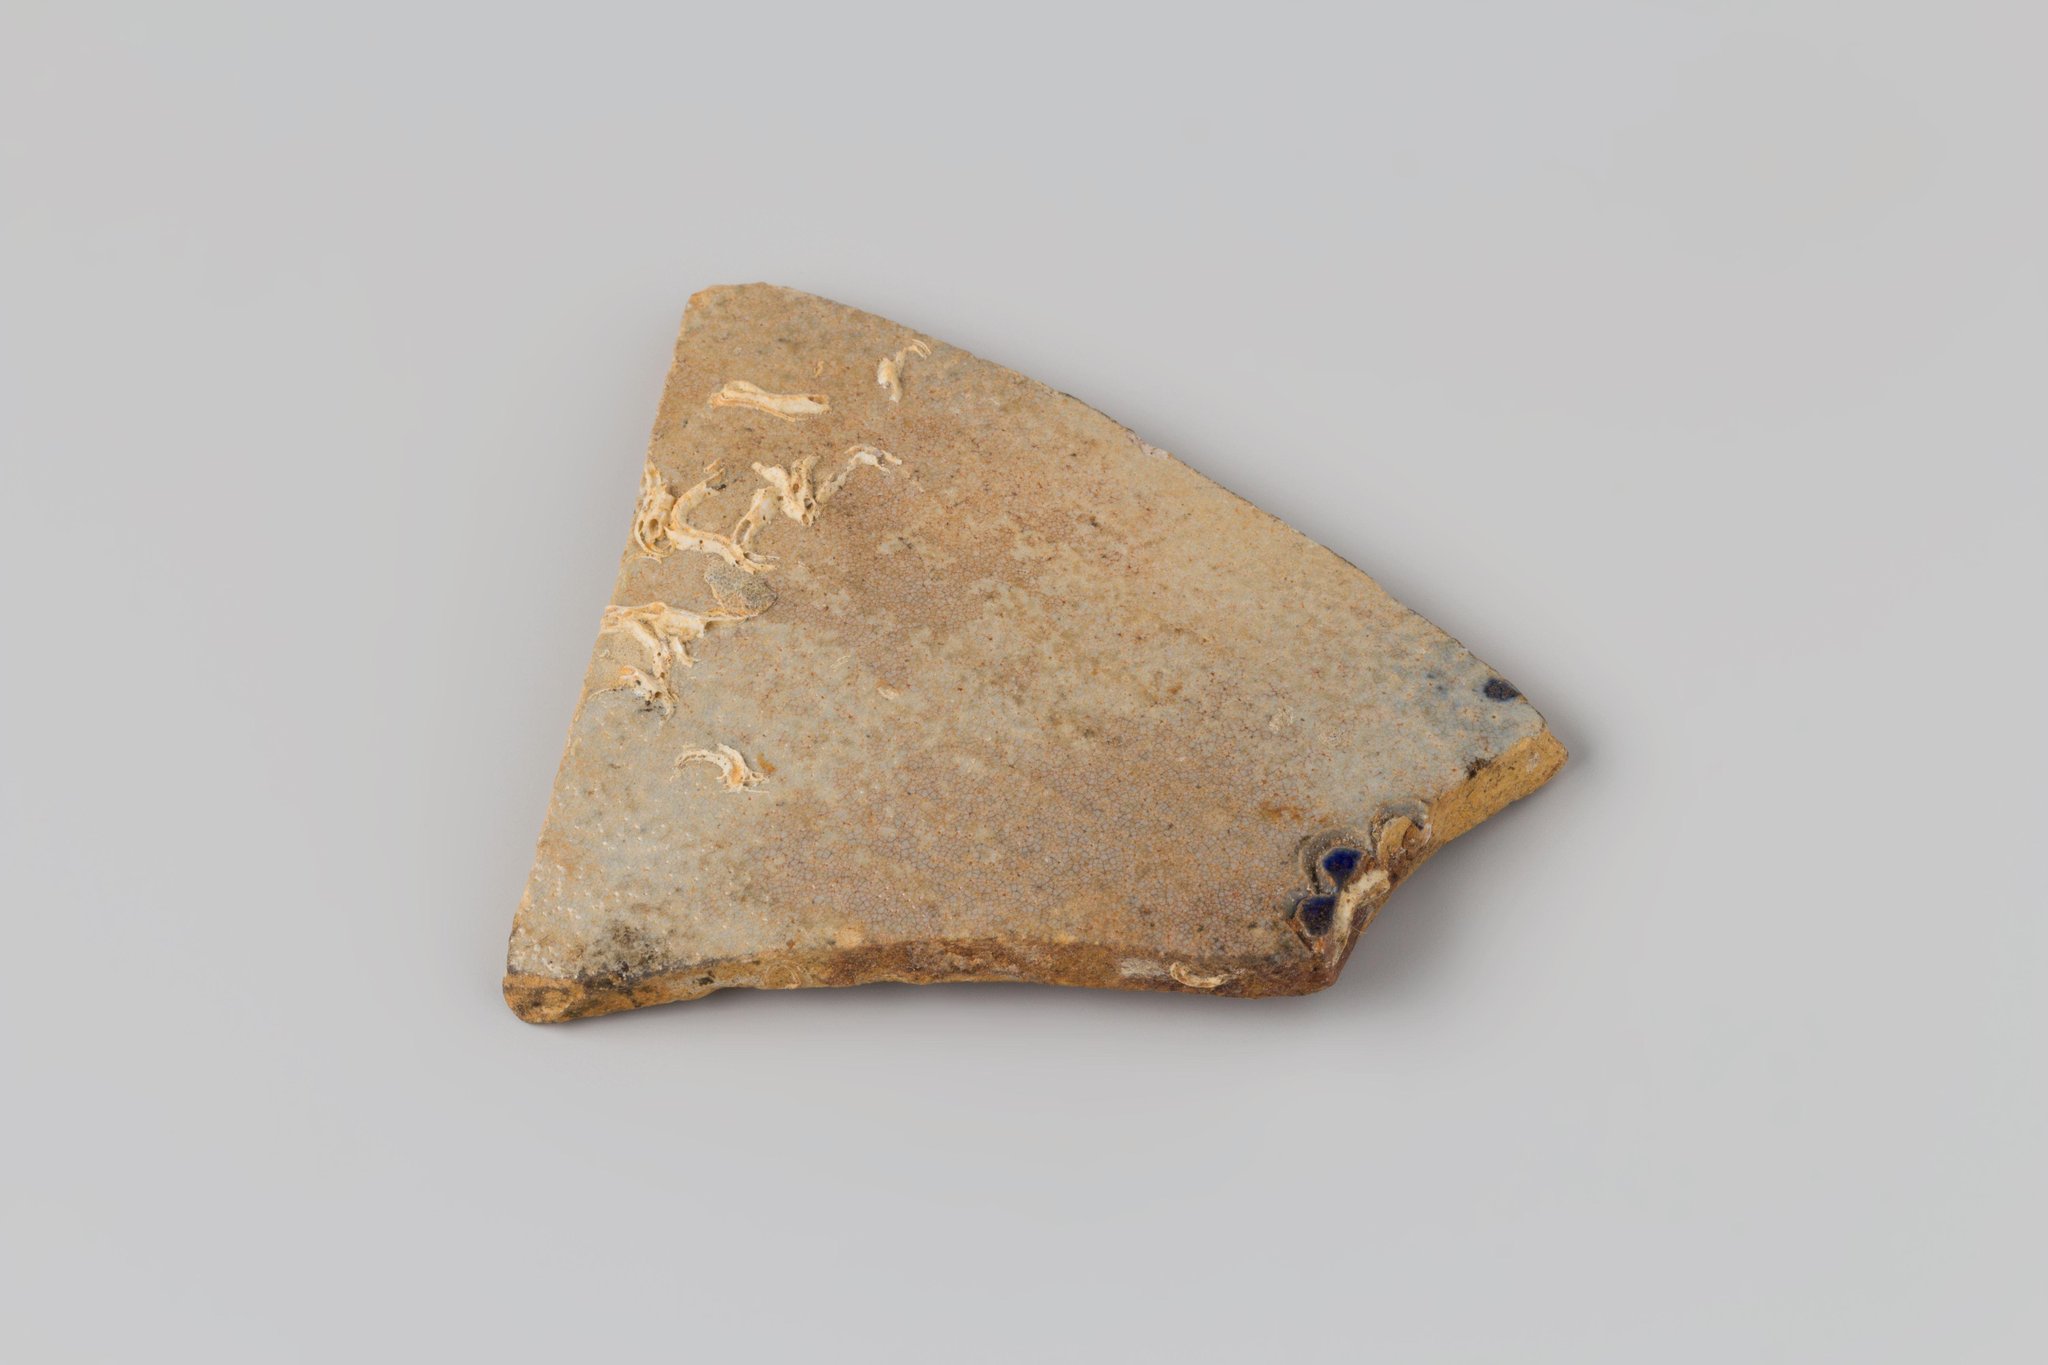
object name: sherd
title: Scherf van een pot uit het wrak van de Oost-Indiëvaarder Hollandia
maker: Anonymous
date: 1700-1743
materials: stoneware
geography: westerwald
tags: verenigde oostindische compagnie, hollandia (schip), annet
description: Stoneware, Rhenish, Westerwald, pot; of body, sim. NG 1980-27H2624r.